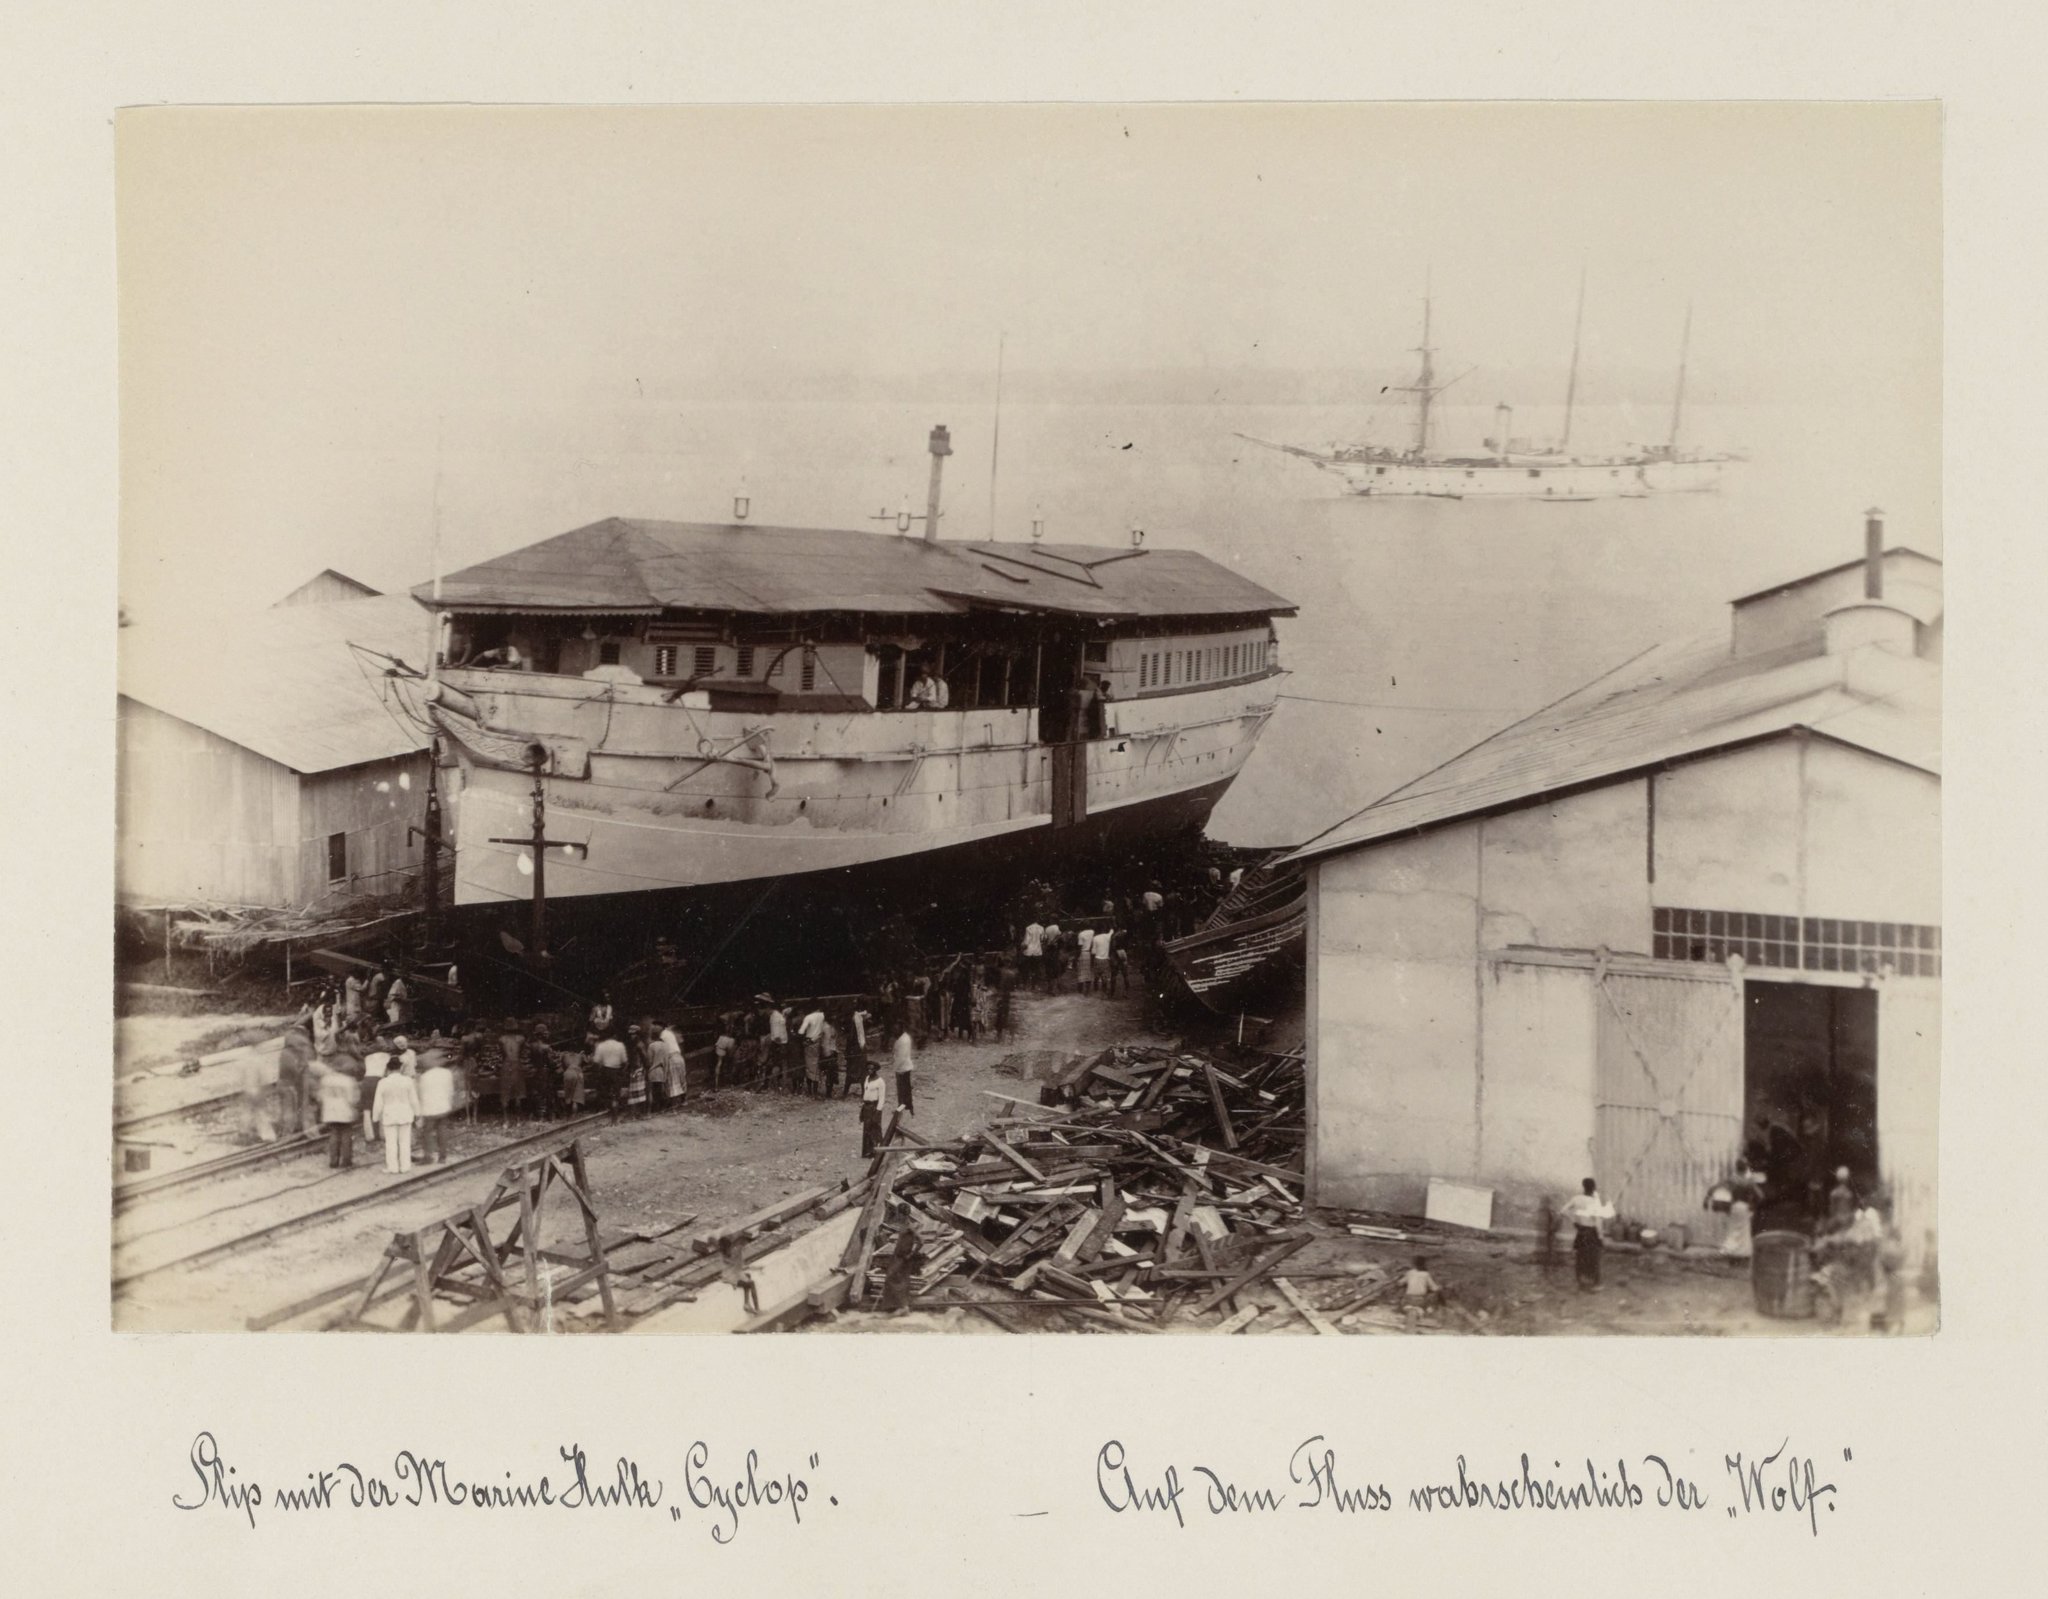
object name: photograph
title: Scheepshelling in Kameroen met de schepen 'Cyclop' en (vermoedelijk) 'Wolf'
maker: Anonymous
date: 1899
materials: photographic support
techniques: albumen print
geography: cameroon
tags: shipyard, shipdock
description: De 'Cyclop' was (vermoedelijk) een zogenaamde 'hulk', een afgedankt schip dat niet zeewaardig was en dienst deed als handelspost. Onderdeel van Fotoalbum met opnames van Kameroen rond 1899.